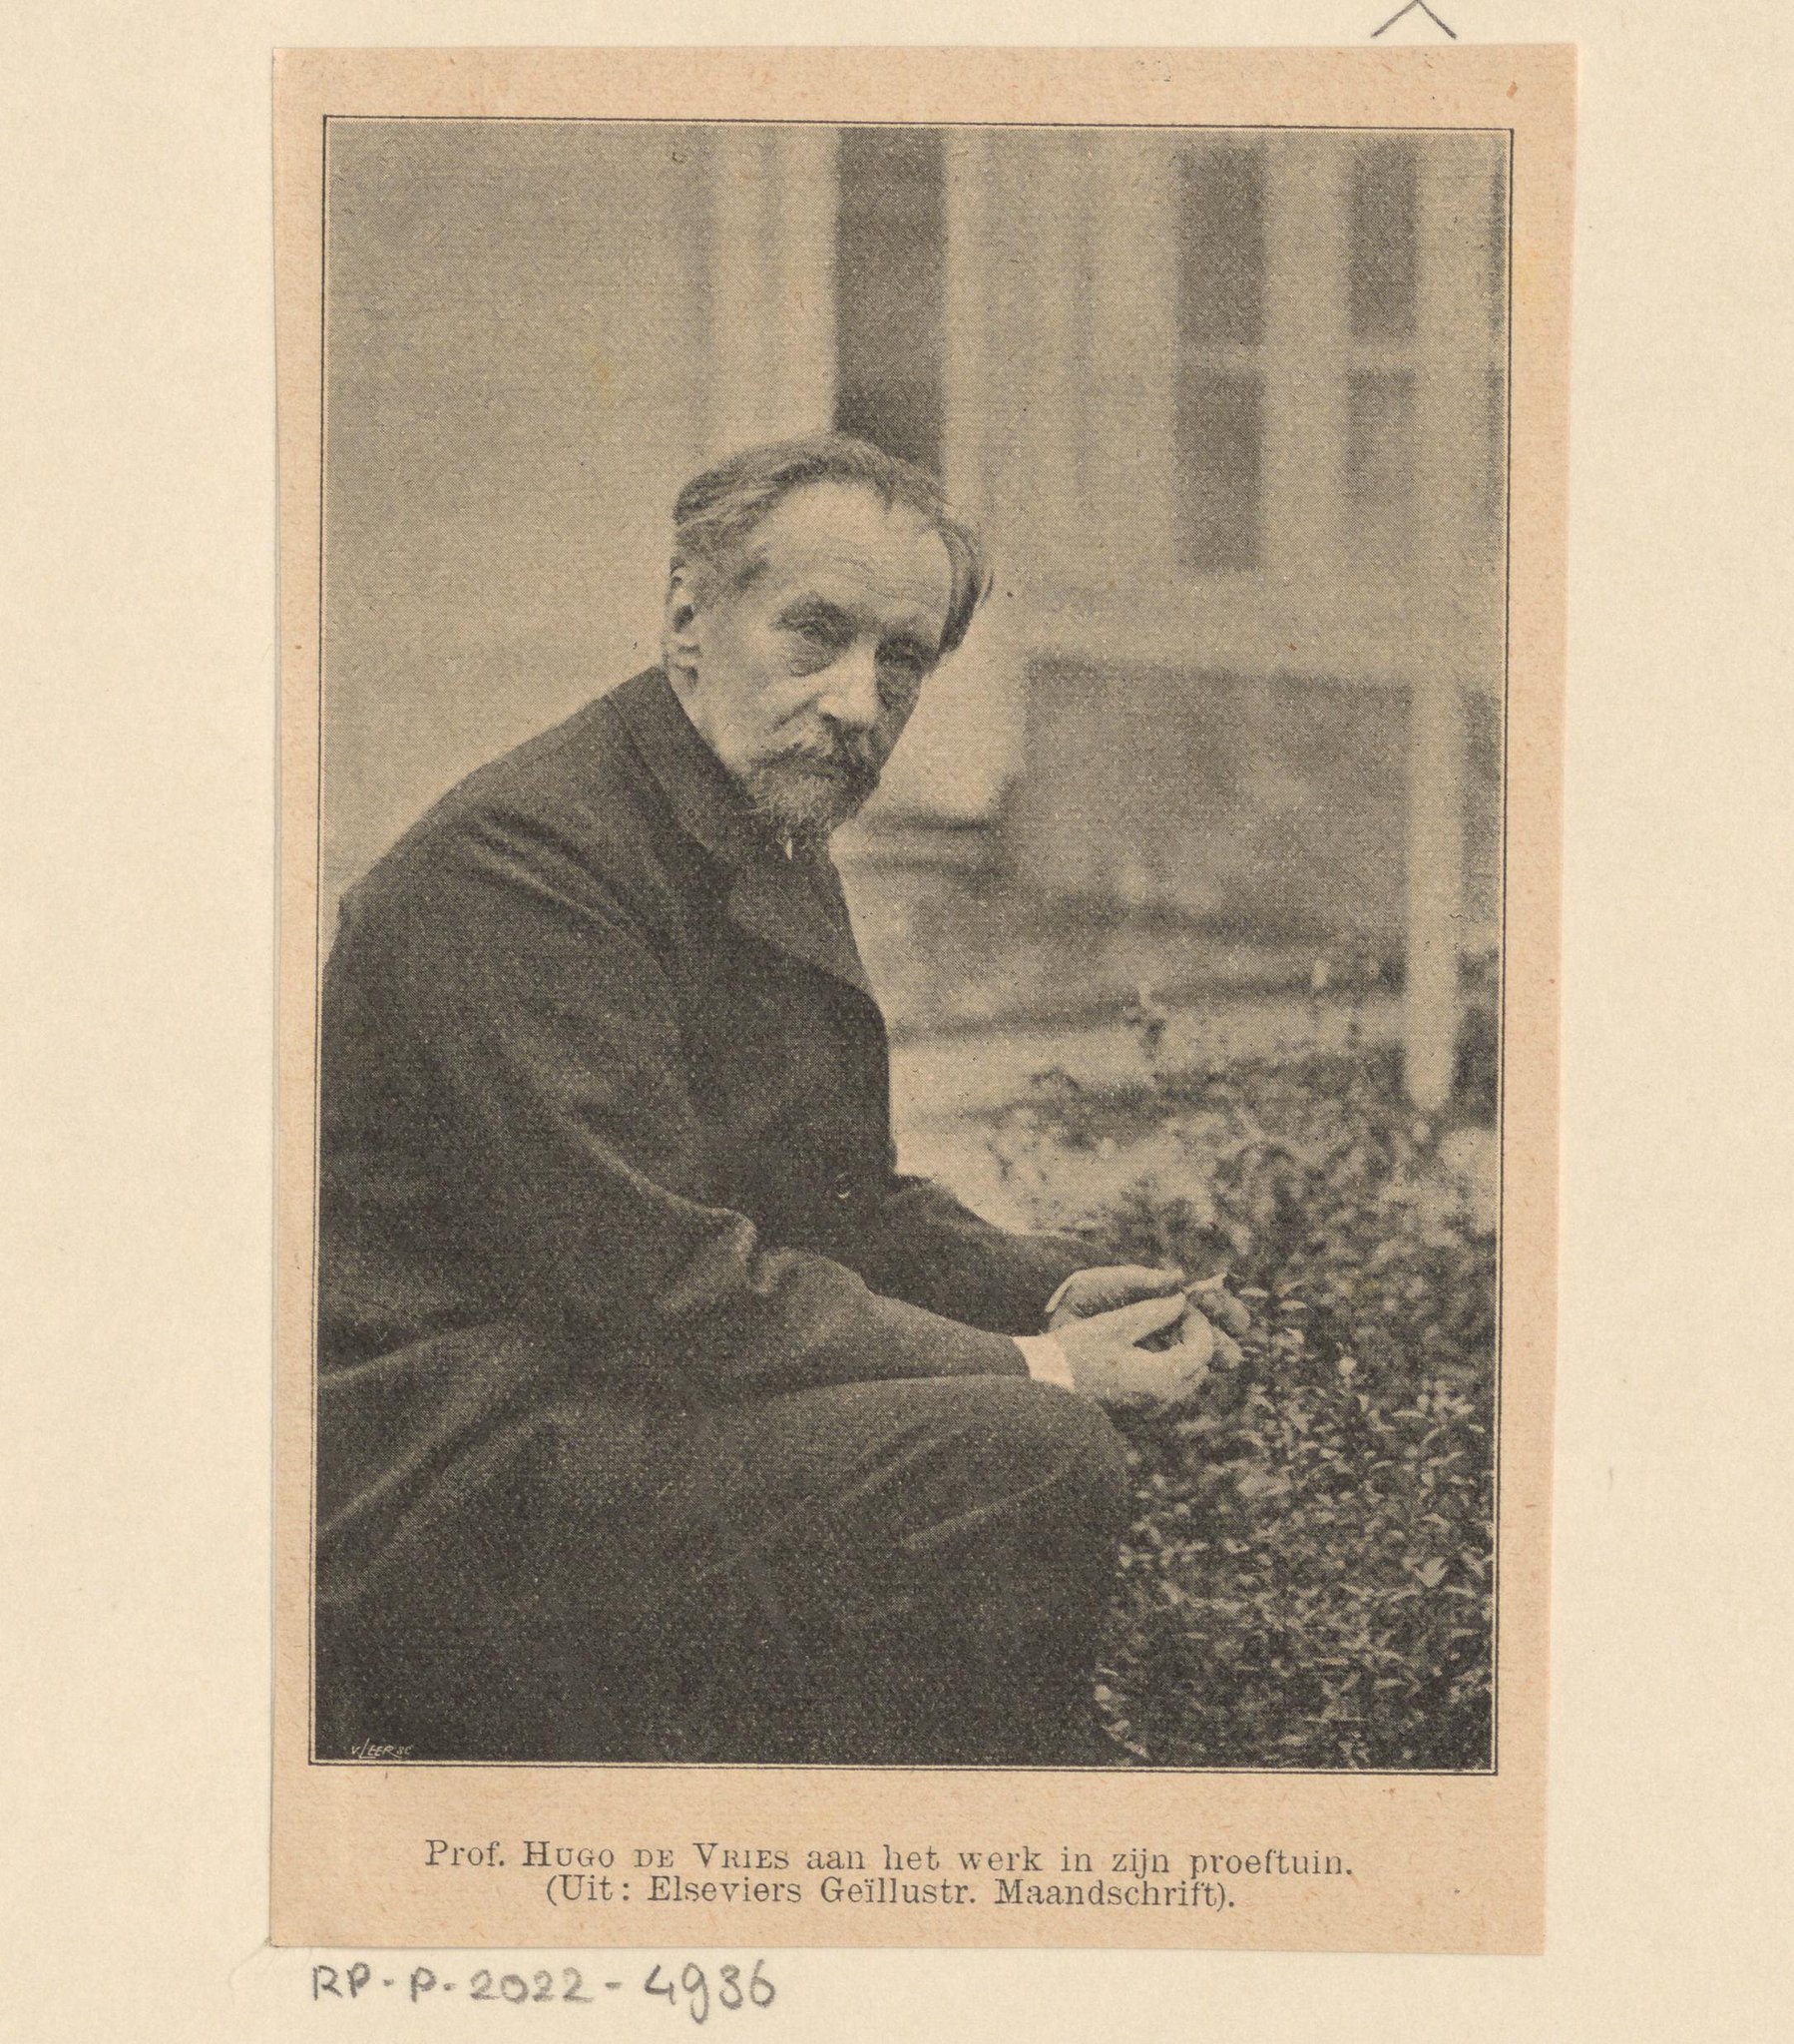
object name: photomechanical print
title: Portret van Hugo de Vries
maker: Anonymous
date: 1905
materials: paper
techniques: autotype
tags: hugo de vries, scholar, philosopher, historical persons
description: Fotomechanische afdruk uit: Elsevier's Geïllustreerd Maandschrift (1905), nr. 15.